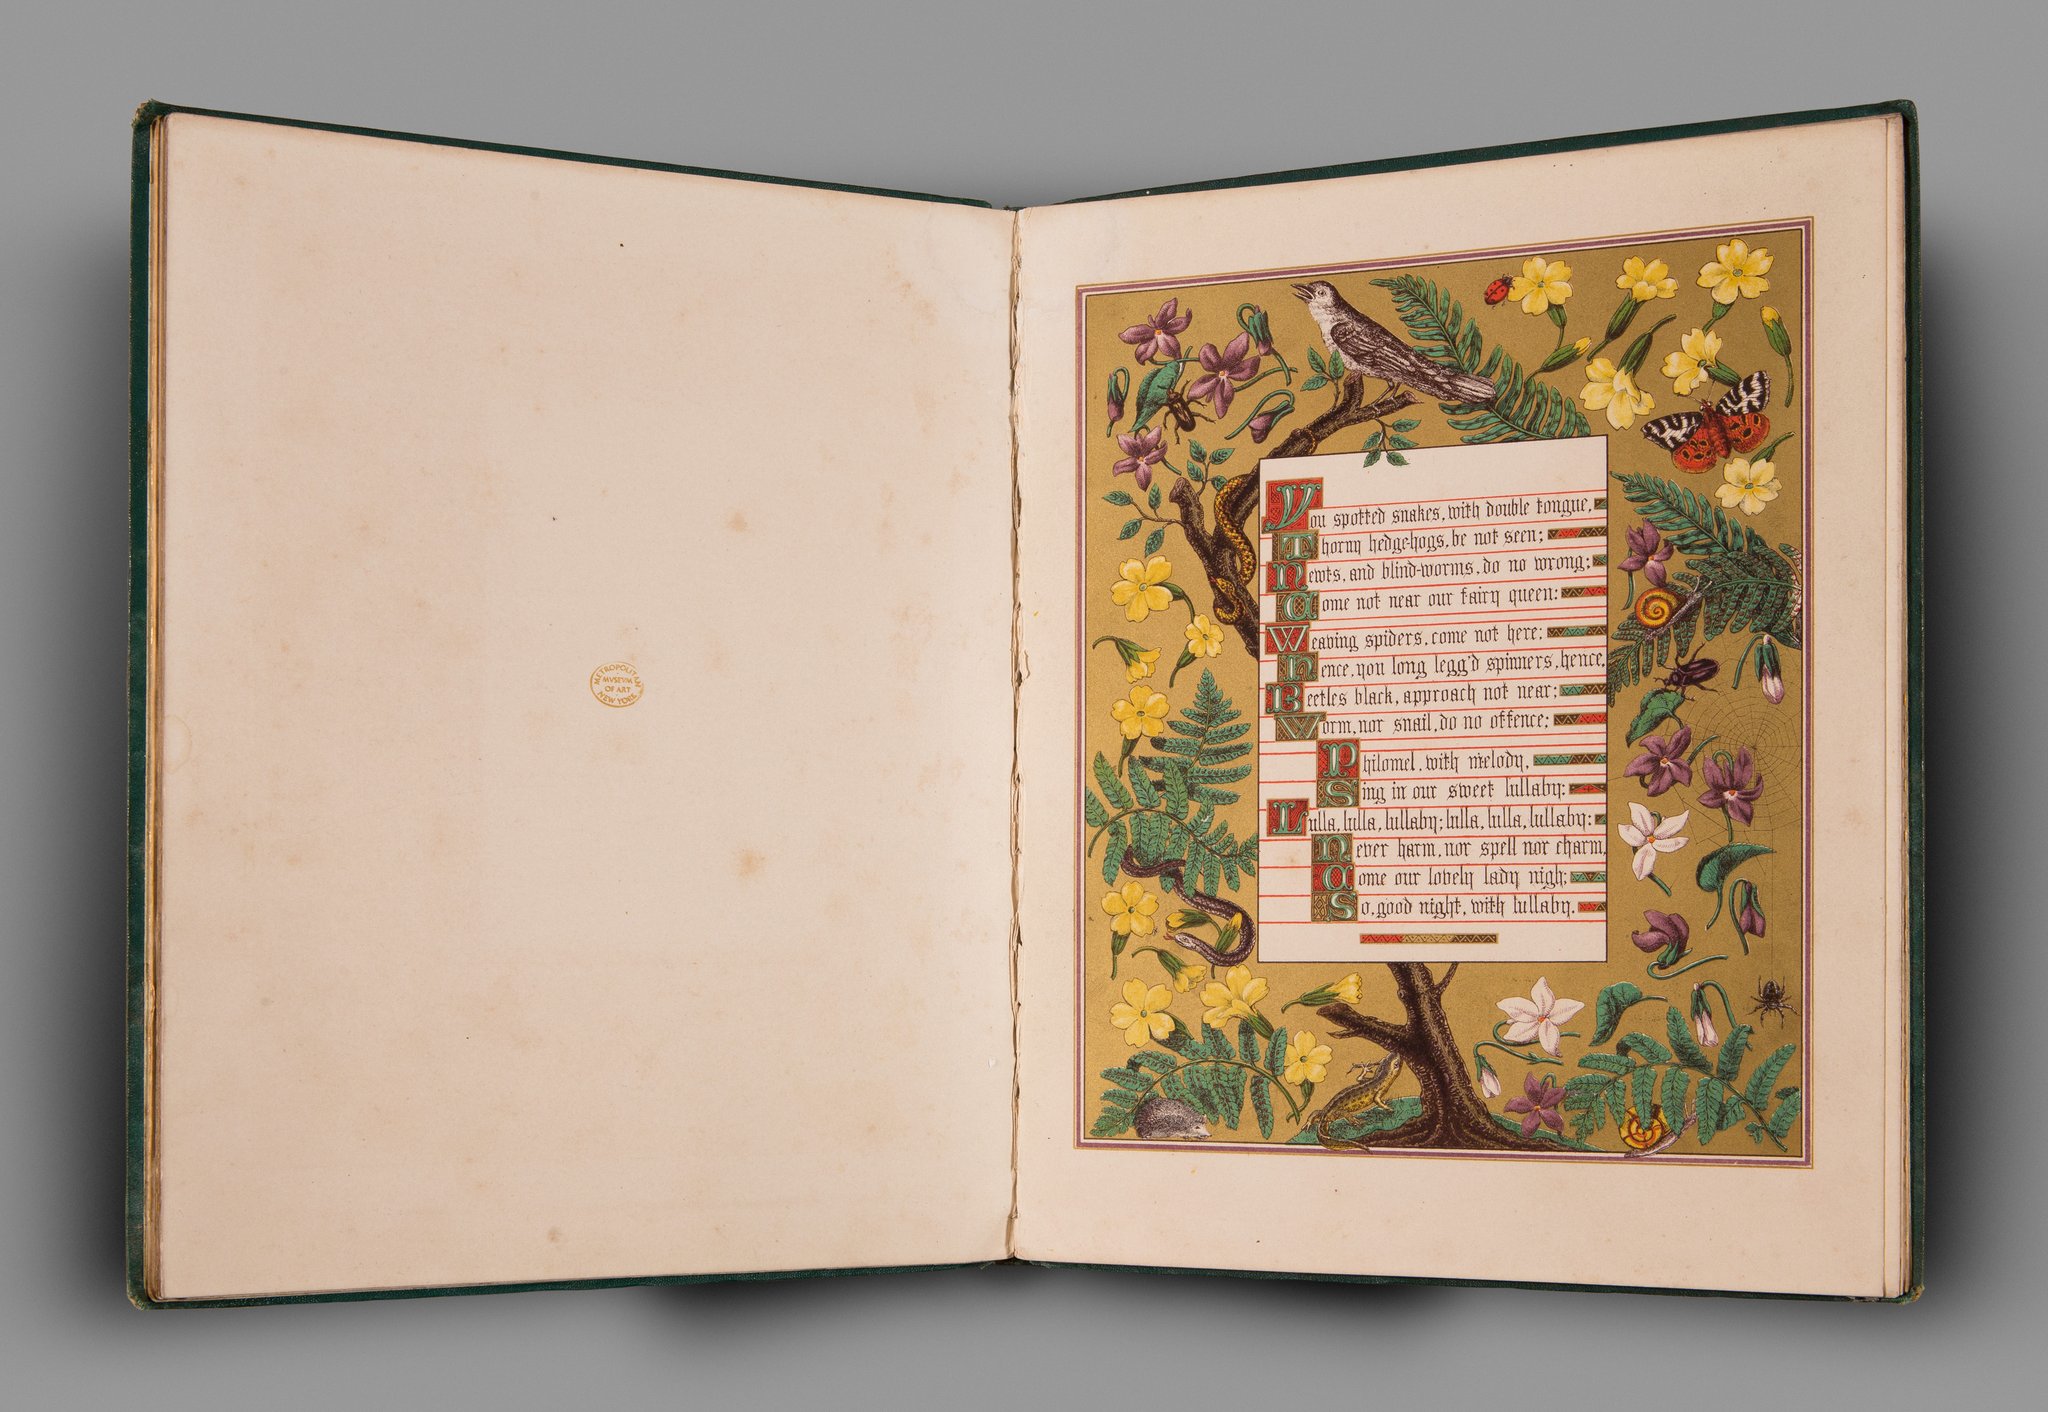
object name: book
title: Songs of Shakespeare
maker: harriette charlotte hoskyns abrahall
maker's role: illustrator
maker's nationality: british, born france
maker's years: 1824-1915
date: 1865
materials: gold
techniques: lithograph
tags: shakespeare